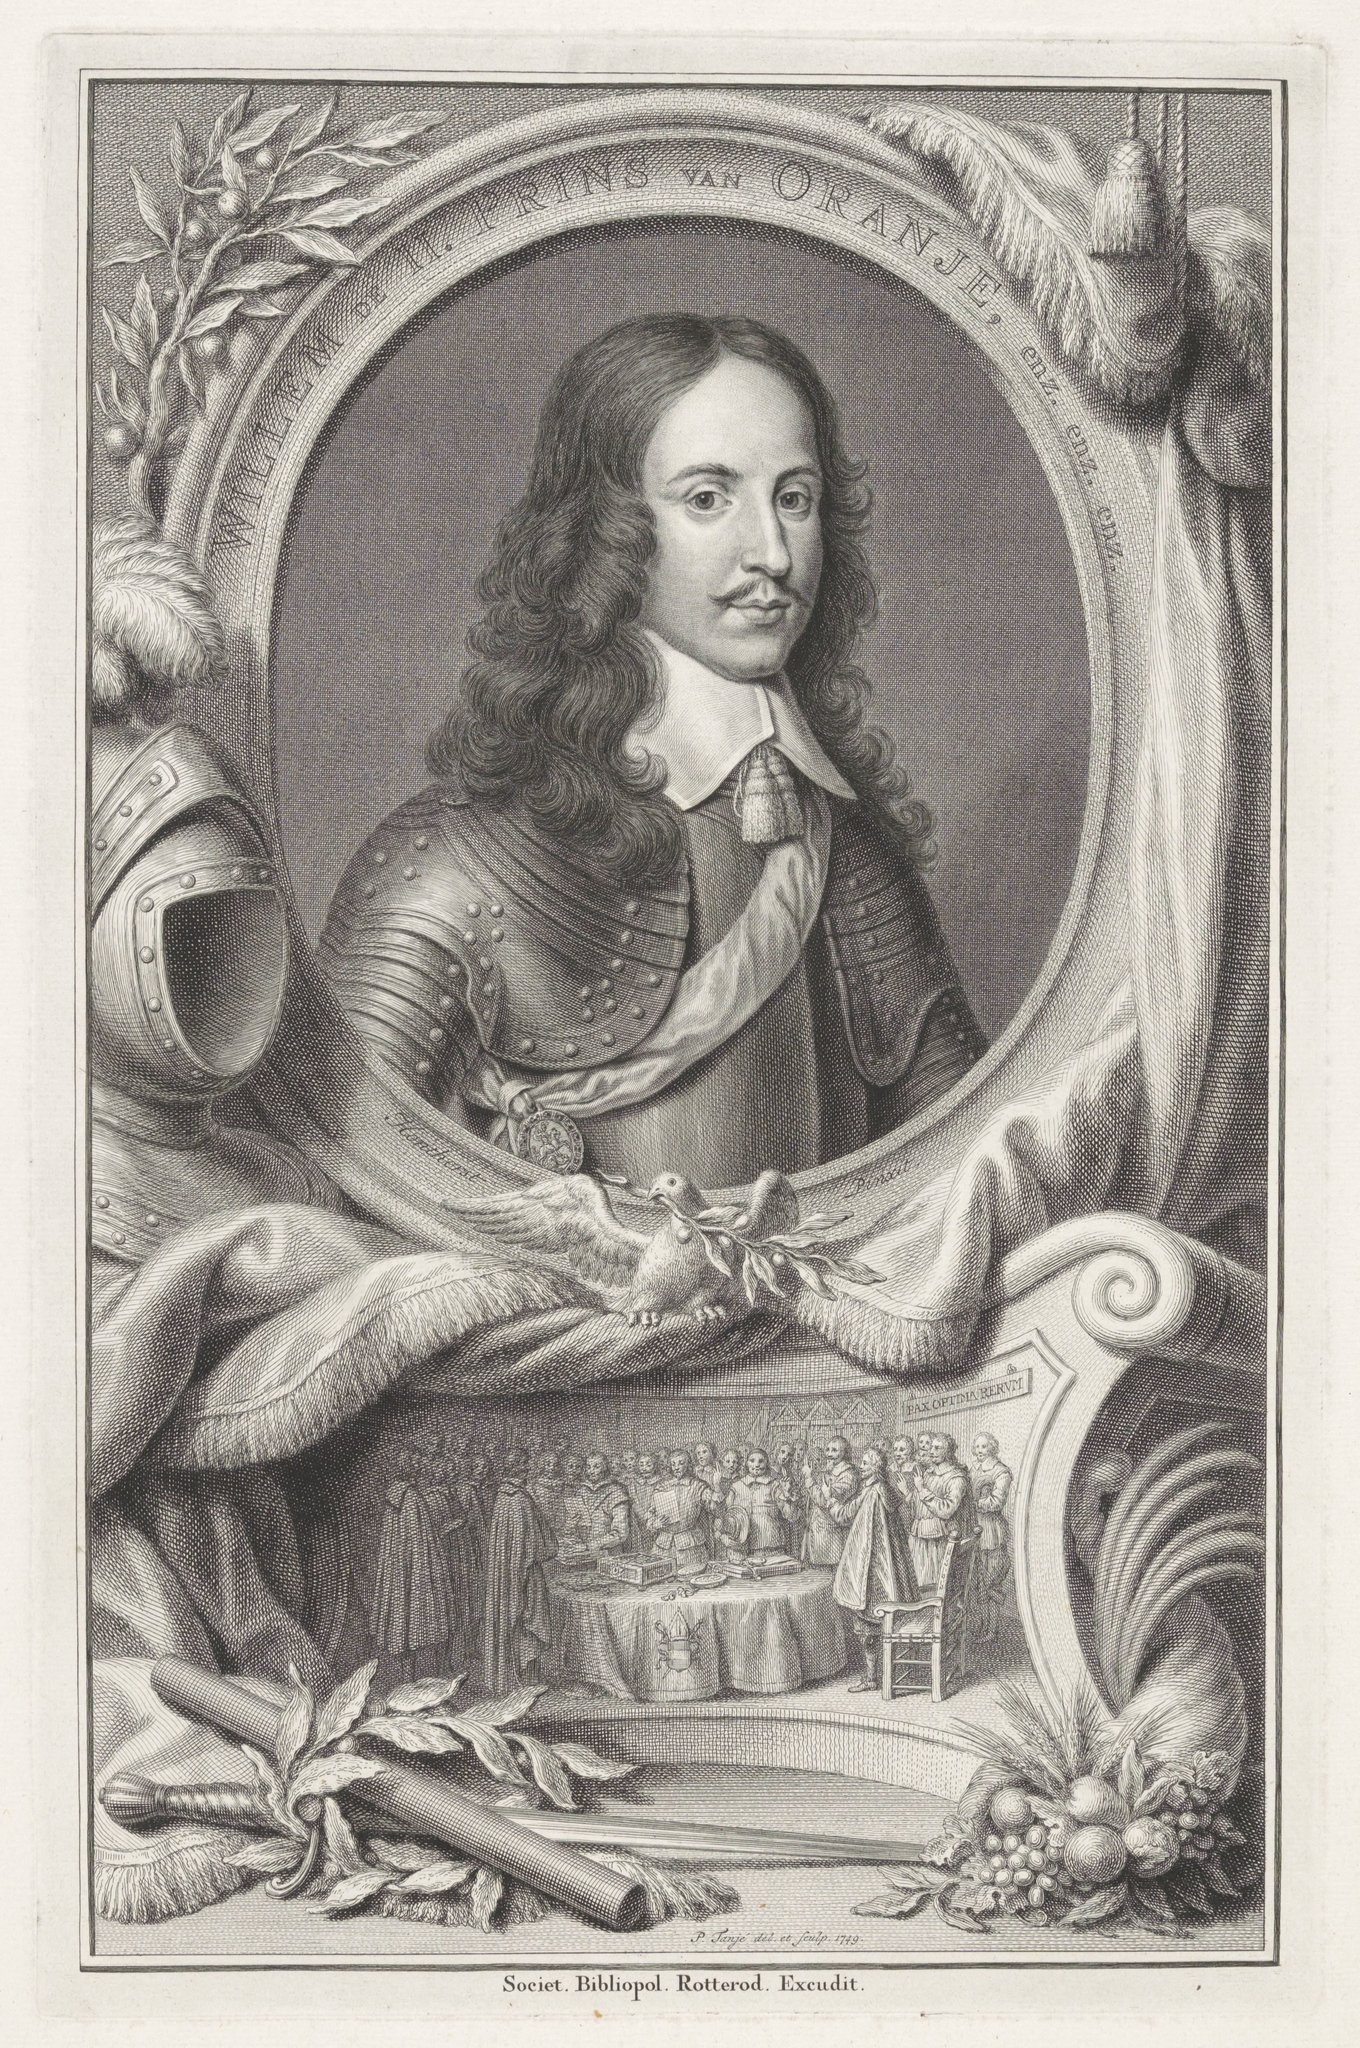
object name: print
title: Portret van Willem II, prins van Oranje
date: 1749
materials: paper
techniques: engraving, etching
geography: rotterdam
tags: william ii (prince of orange), knighthood order (garter) - insignia of a knighthood order, e.g.: badge, chain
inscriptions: date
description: Portret van Willem II in een ovaal met randschrift. Rondom ligt een aantal allegorische objecten, waaronder een commandostaf, een lauwerkrans en een helm. Op het reliëf het beëdigen van de Vrede van Munster, 15 mei 1648.